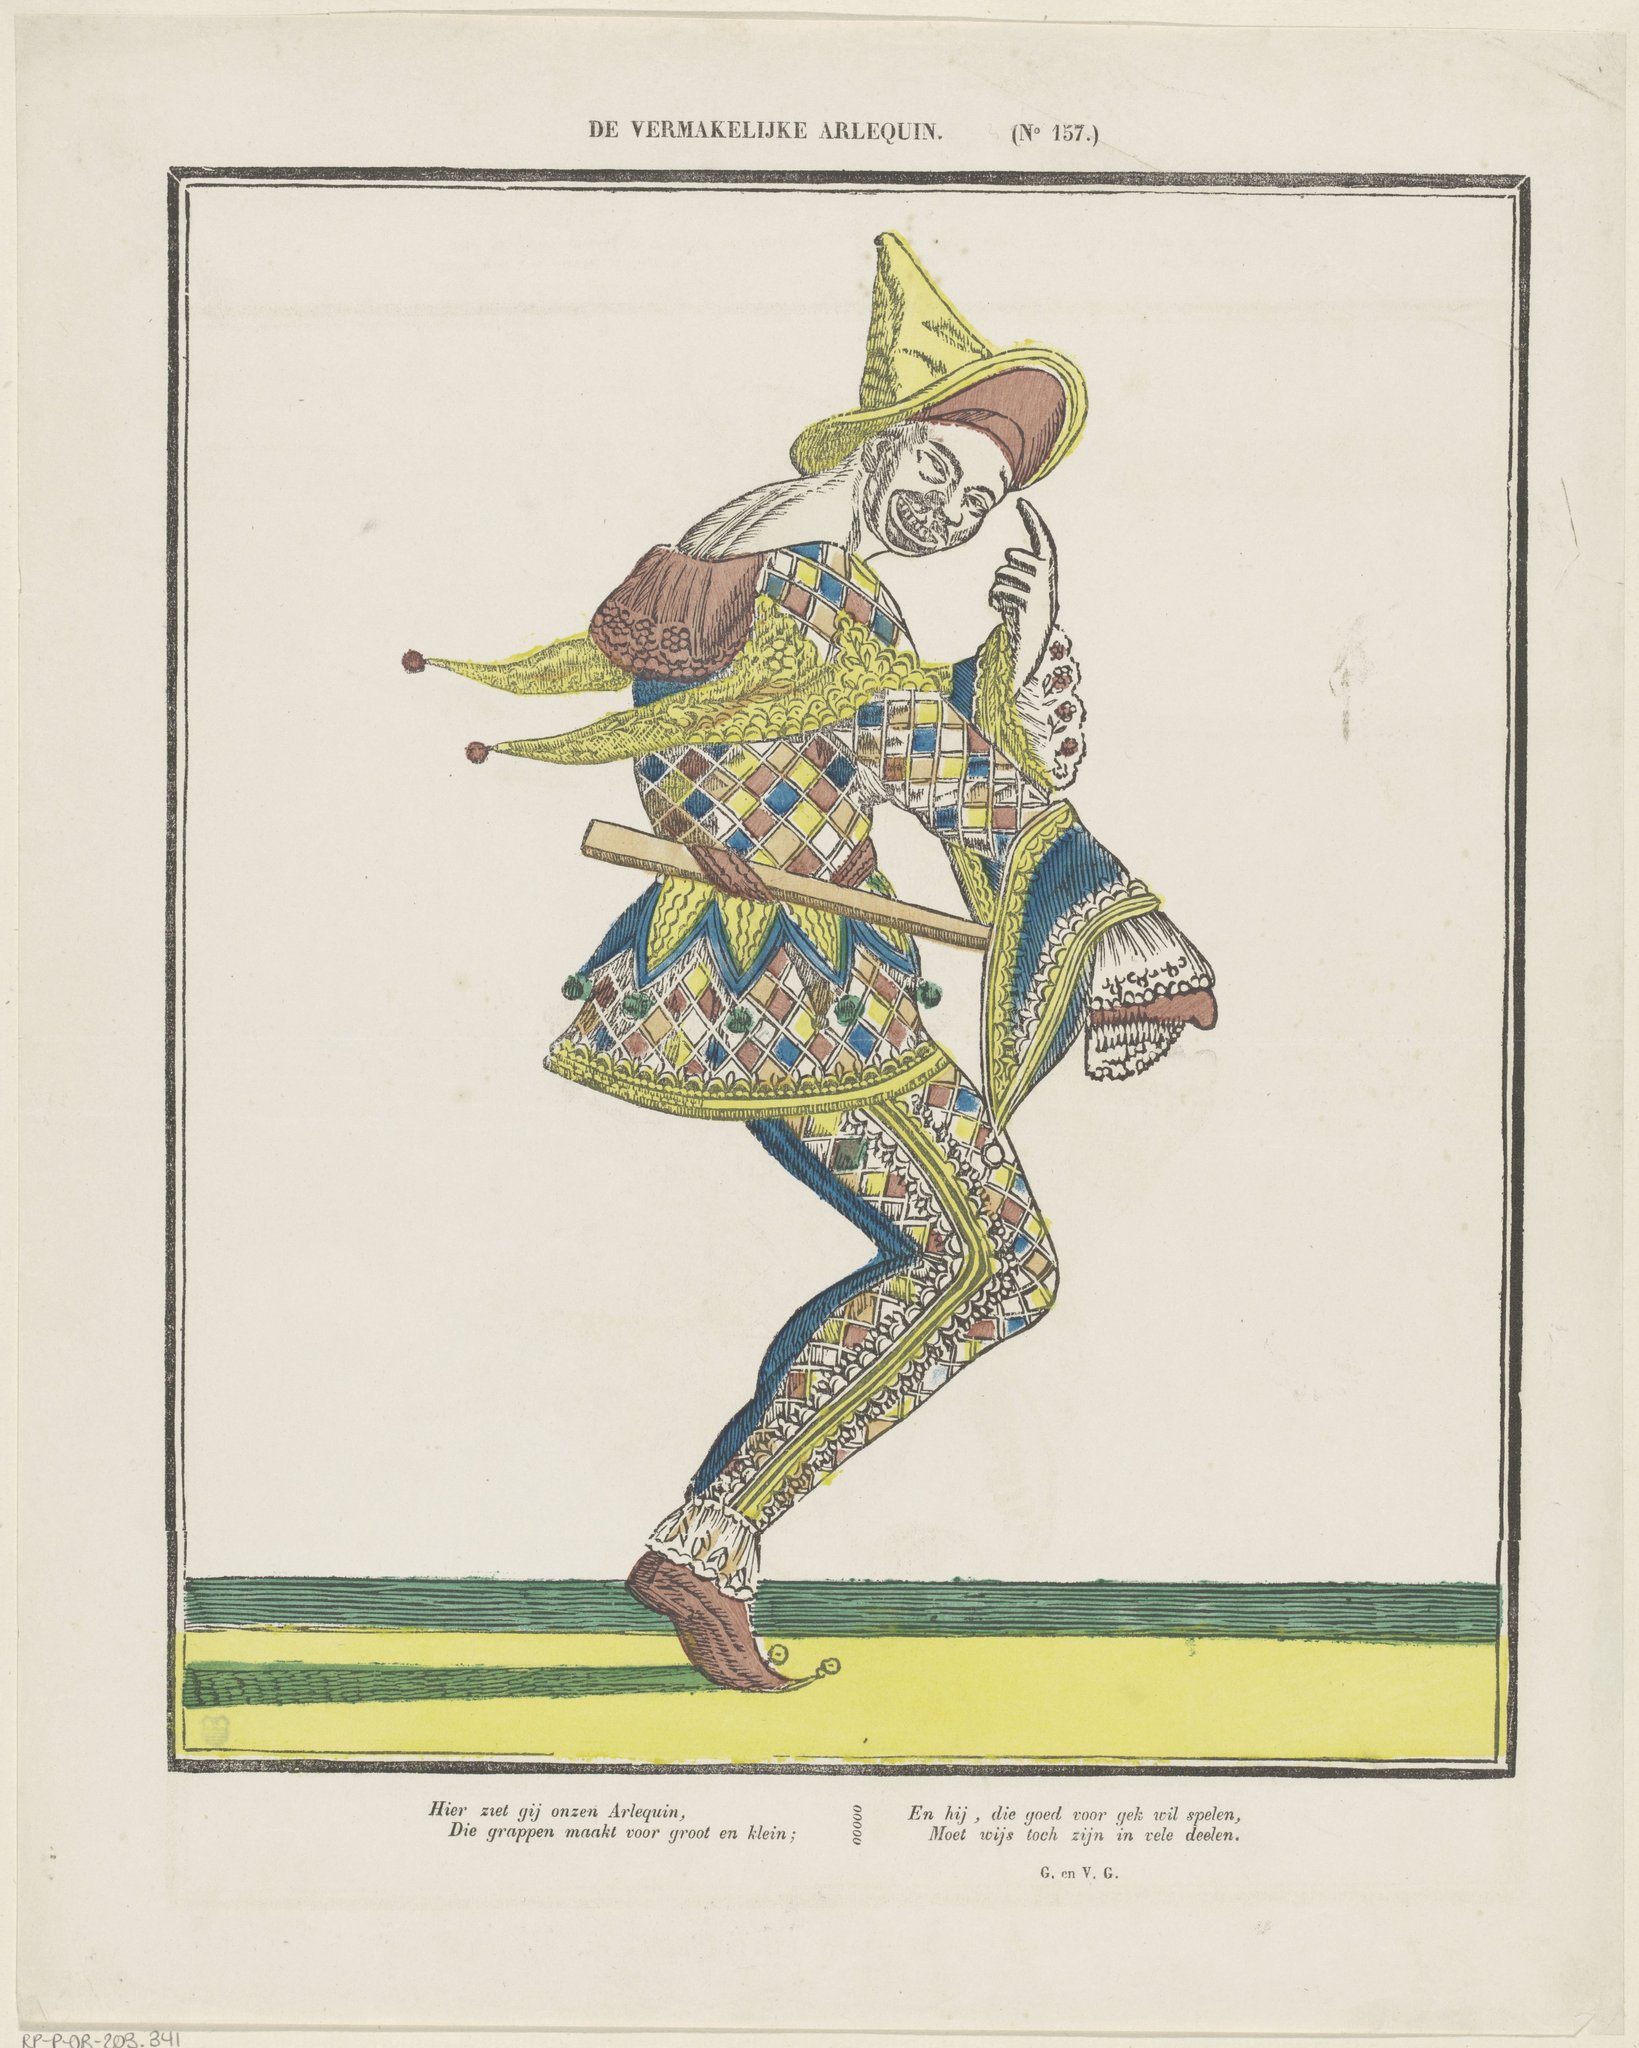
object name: print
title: De vermakelijke Arlequin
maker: Anonymous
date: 1833-1856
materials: paper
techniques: colour, letterpress printing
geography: turnhout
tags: types in 'commedia dell'arte': harlequin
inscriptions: collector's mark: Lugt 2760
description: Blad met een grote voorstelling van Harlekijn. In de ondermarge een vierregelig vers in twee kolommen. Genummerd midden boven: (No 157.).